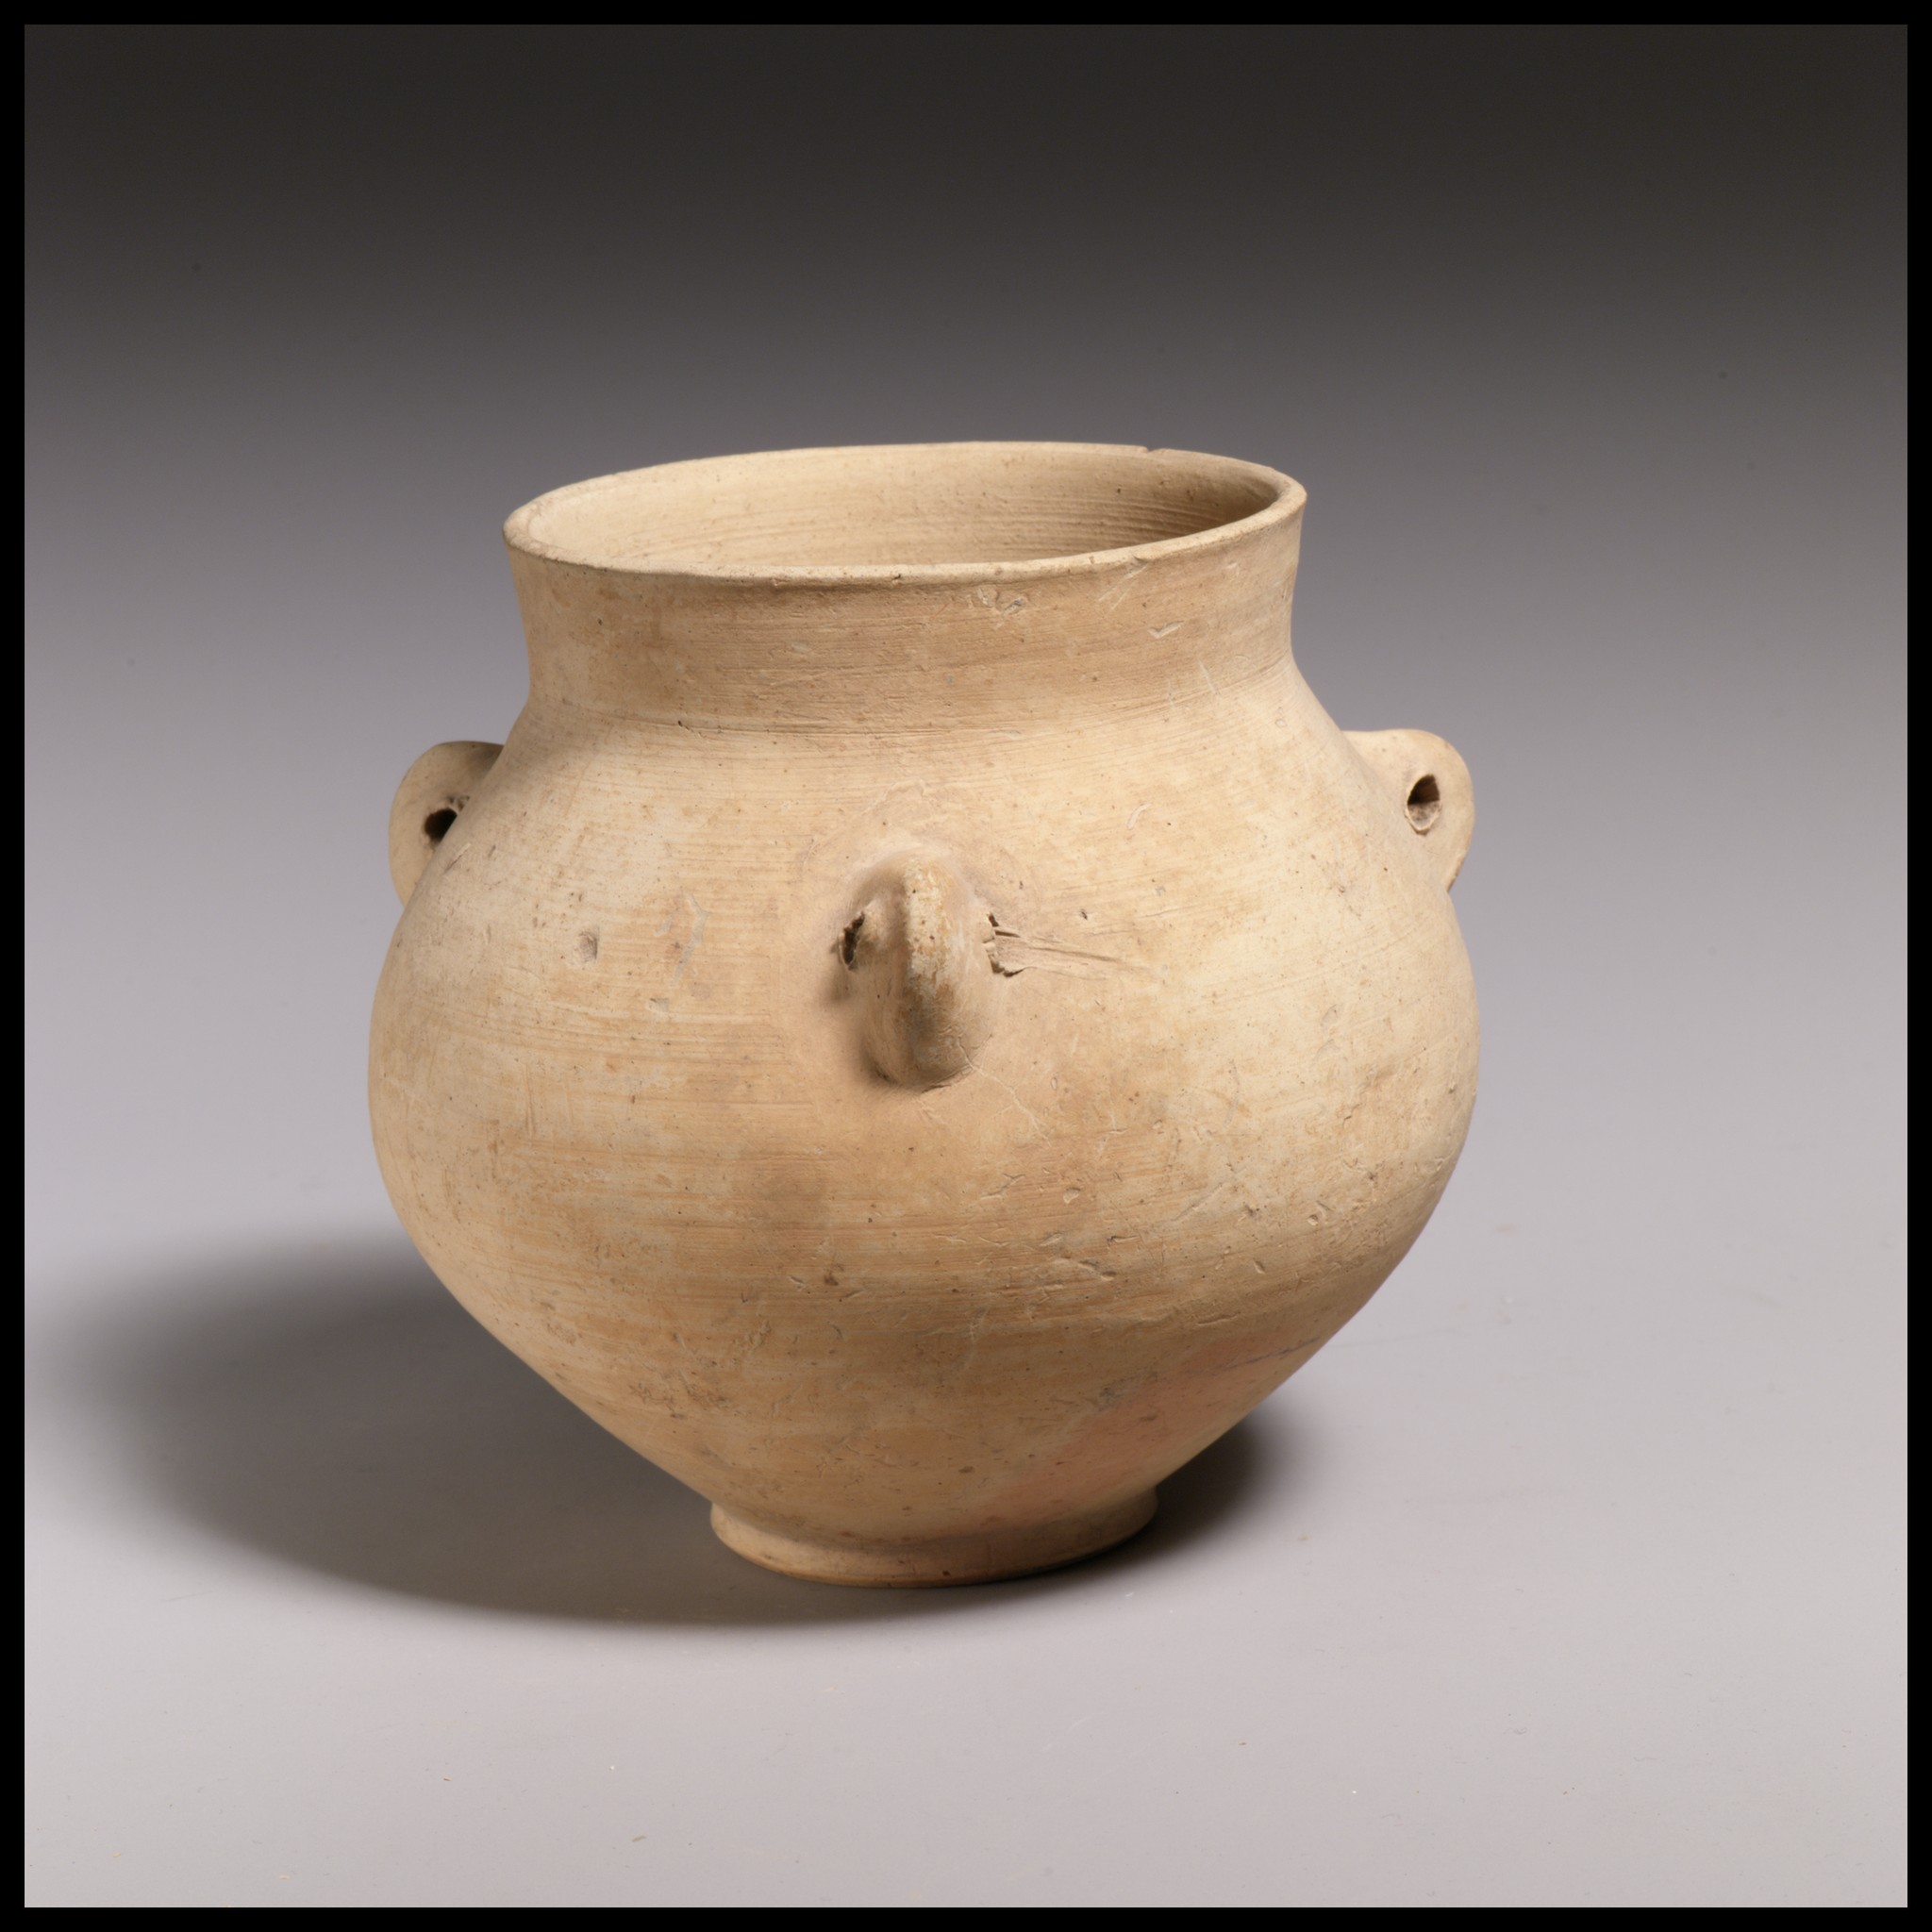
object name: jug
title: Terracotta collar-necked jar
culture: mycenaean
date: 1400-1190 BCE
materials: terracotta